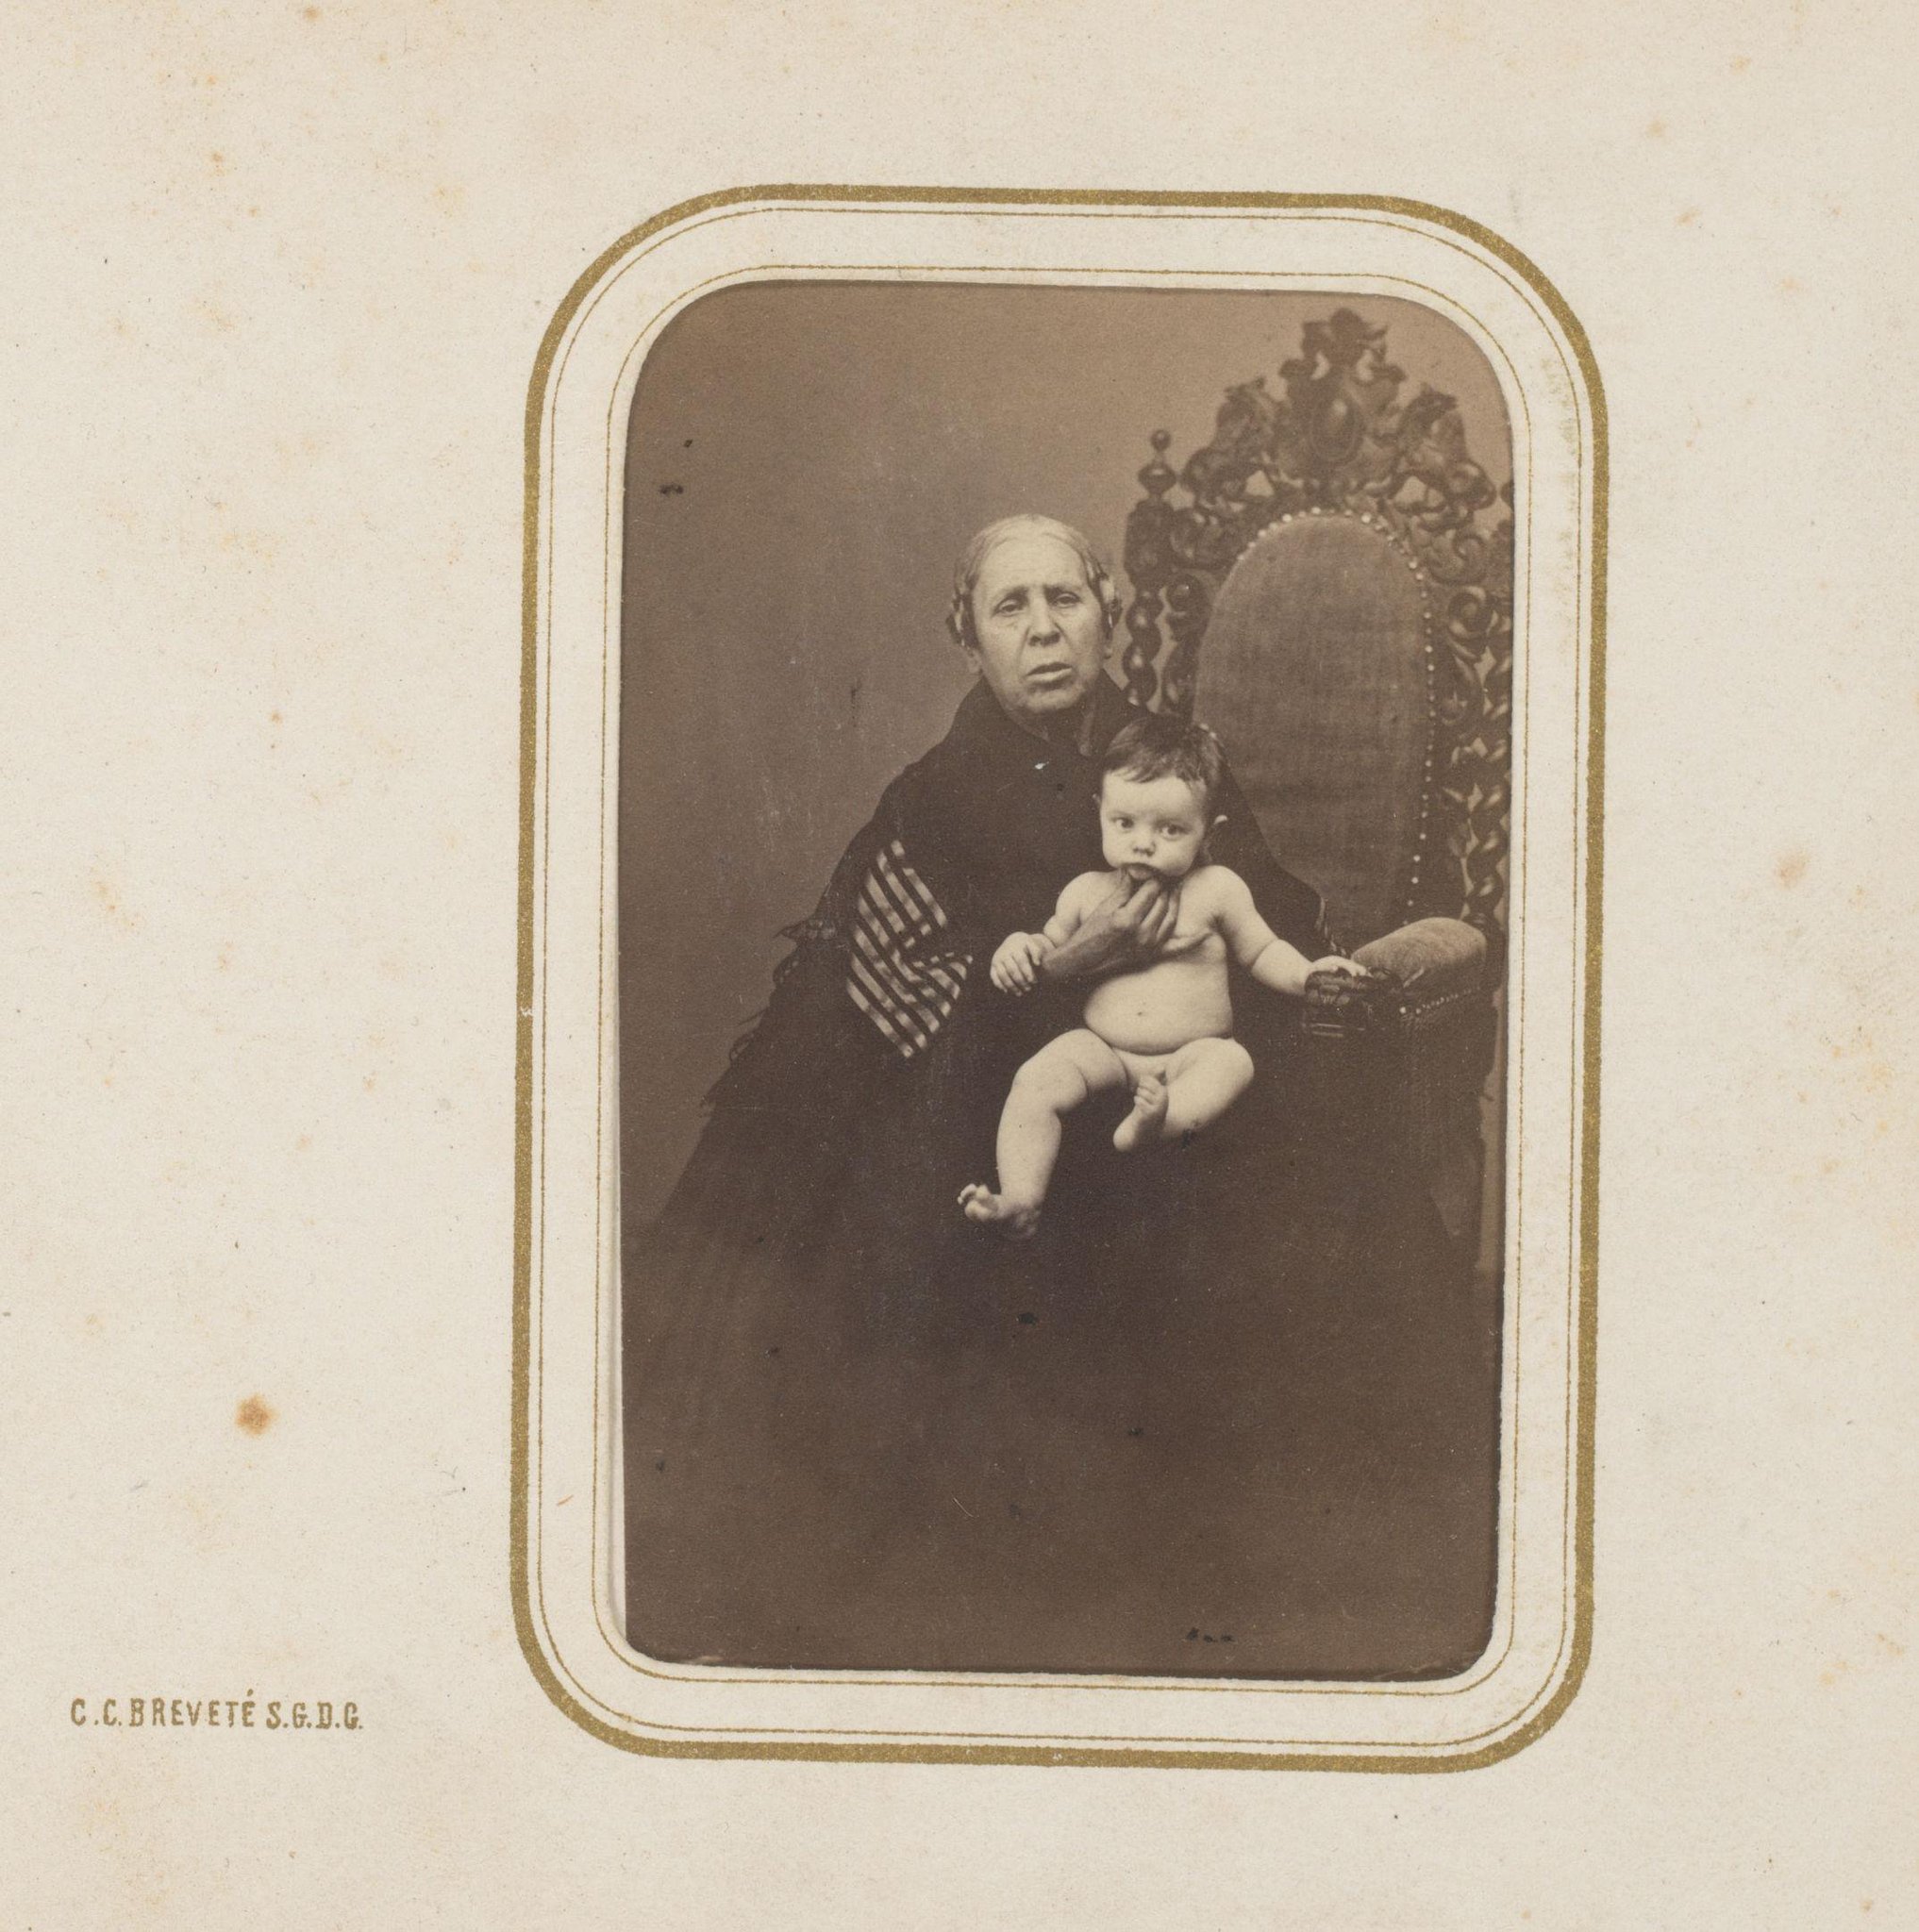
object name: album leaf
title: Portret van een vrouw met baby op schoot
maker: josé garcía ayola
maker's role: fotograaf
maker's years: 1836-1900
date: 1860-1900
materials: cardboard, photographic support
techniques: albumen print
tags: historical persons, infant, baby, mother and child(ren), woman and child(ren) (family group)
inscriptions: inscription: ‘J. García Ayola/ Fotografo/ Calle deLucena No. 3./ Granada’